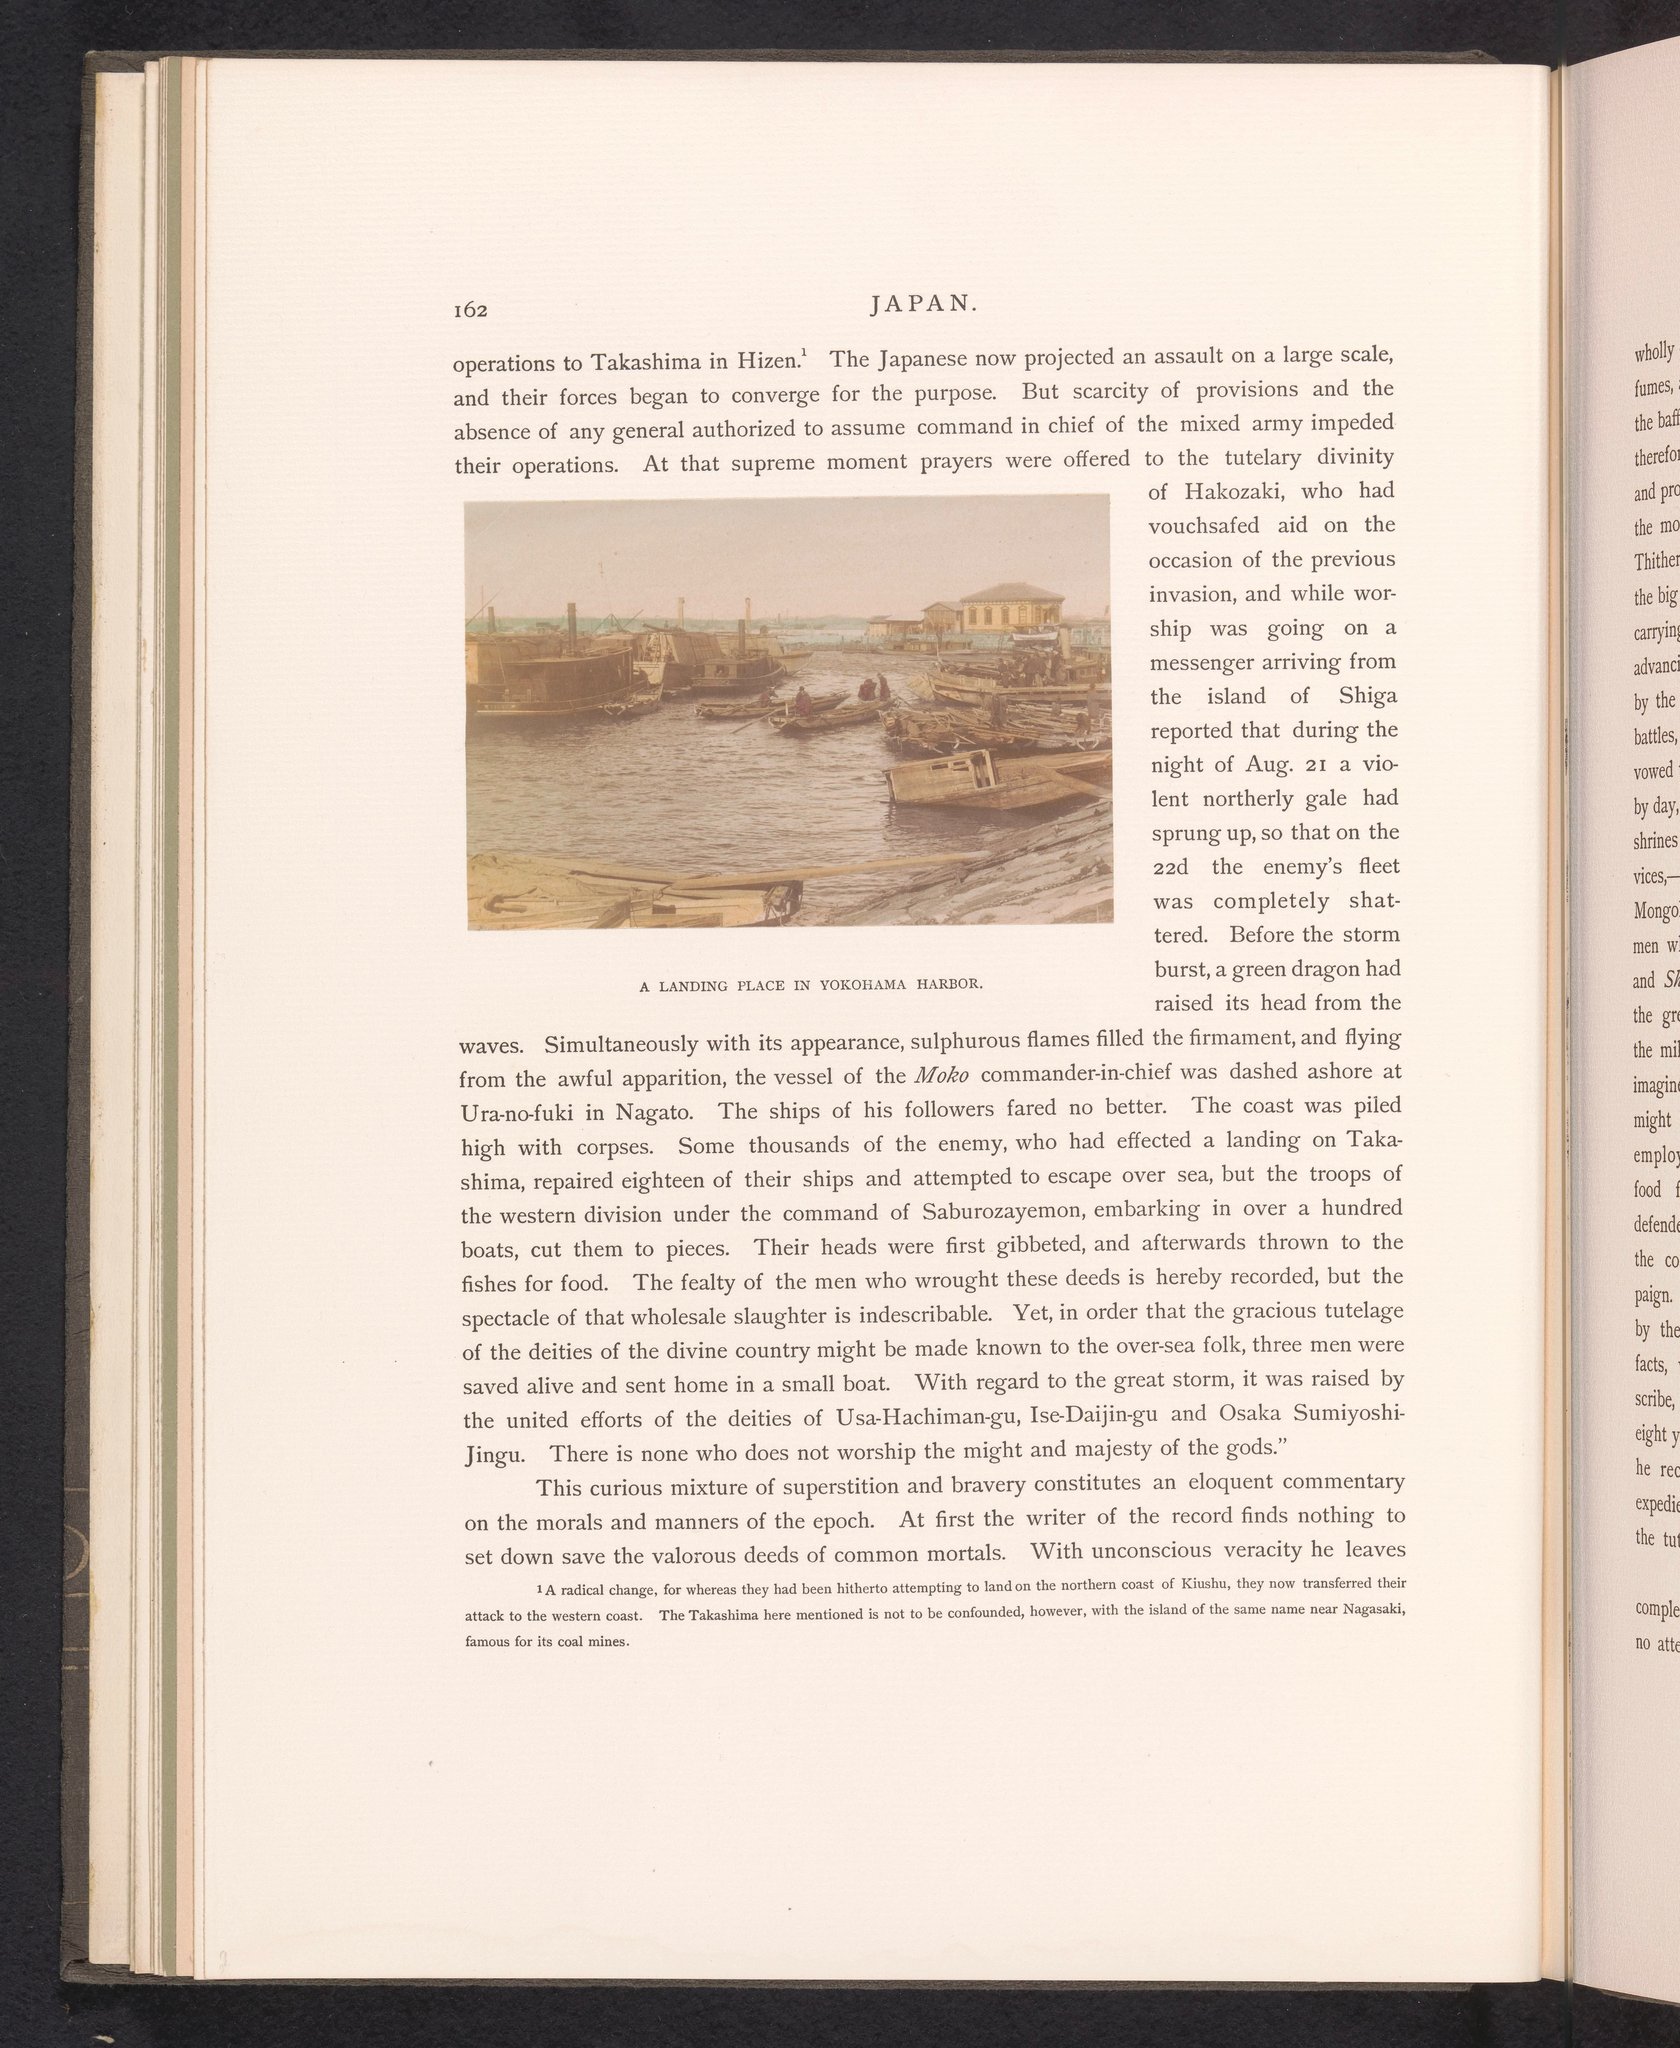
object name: page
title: A landing place in Yokohama harbor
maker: Anonymous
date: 1887-1897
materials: photographic support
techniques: albumen print, hand coloring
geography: japan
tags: harbour, ships (in general)